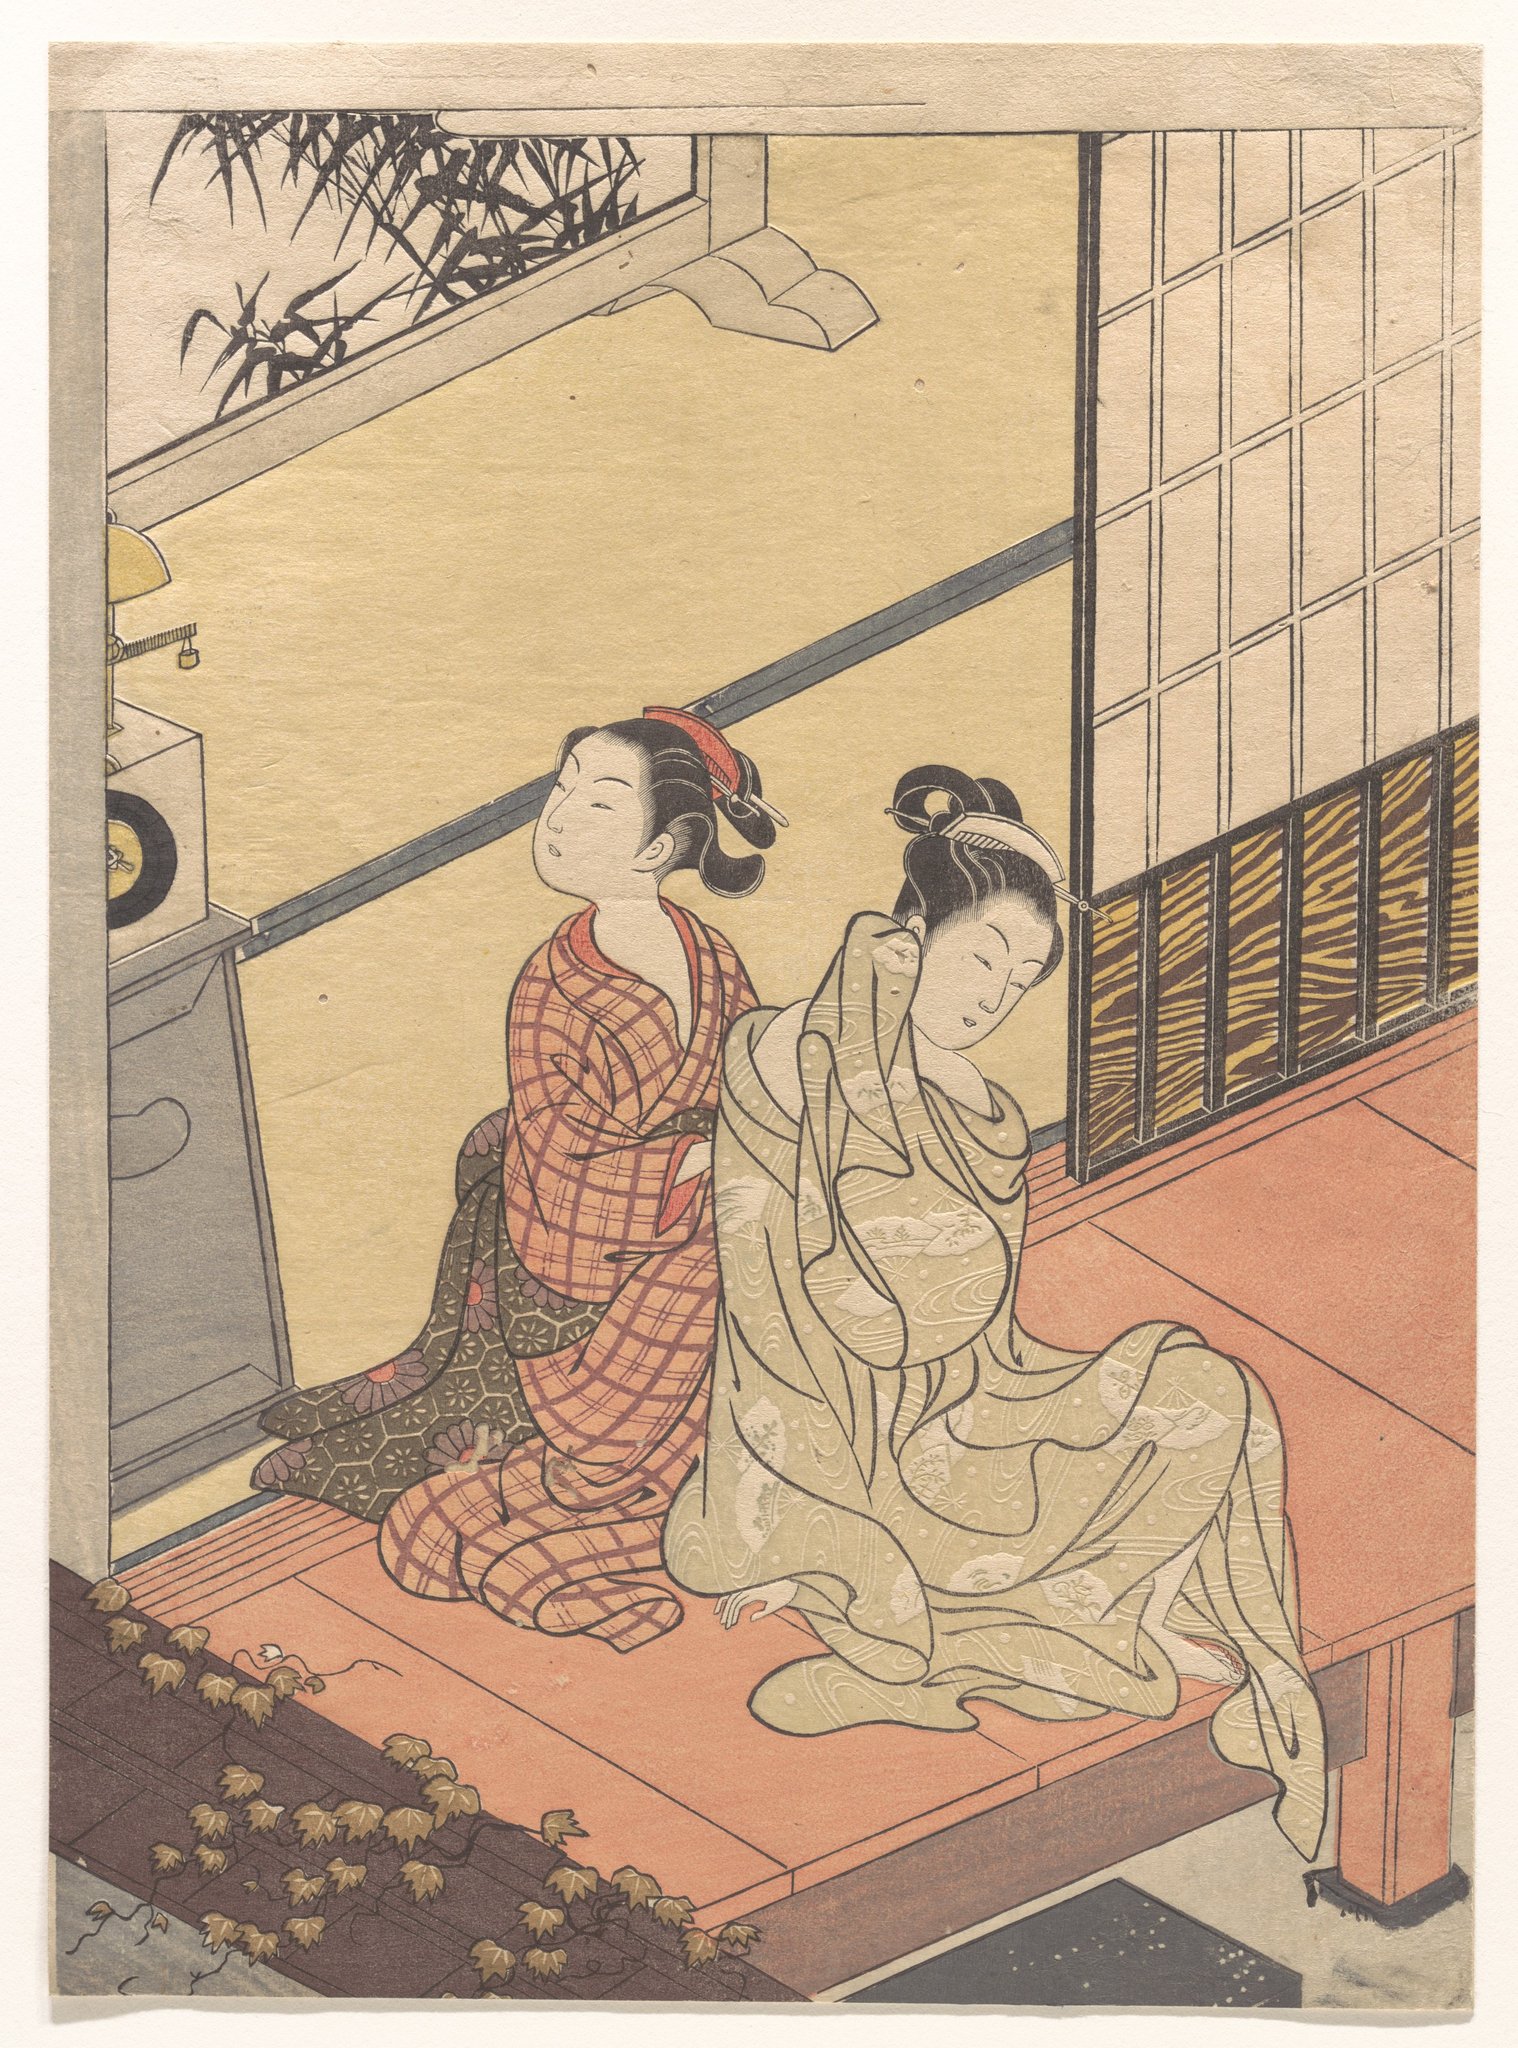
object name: print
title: Evening Chime of the Clock (Tokei no banshō), from the series “Eight Parlor Views” (Zashiki hakkei)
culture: japanese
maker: suzuki harunobu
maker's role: artist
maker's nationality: japanese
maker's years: 1725-1770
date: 1766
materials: ink, paper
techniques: woodblock print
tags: women